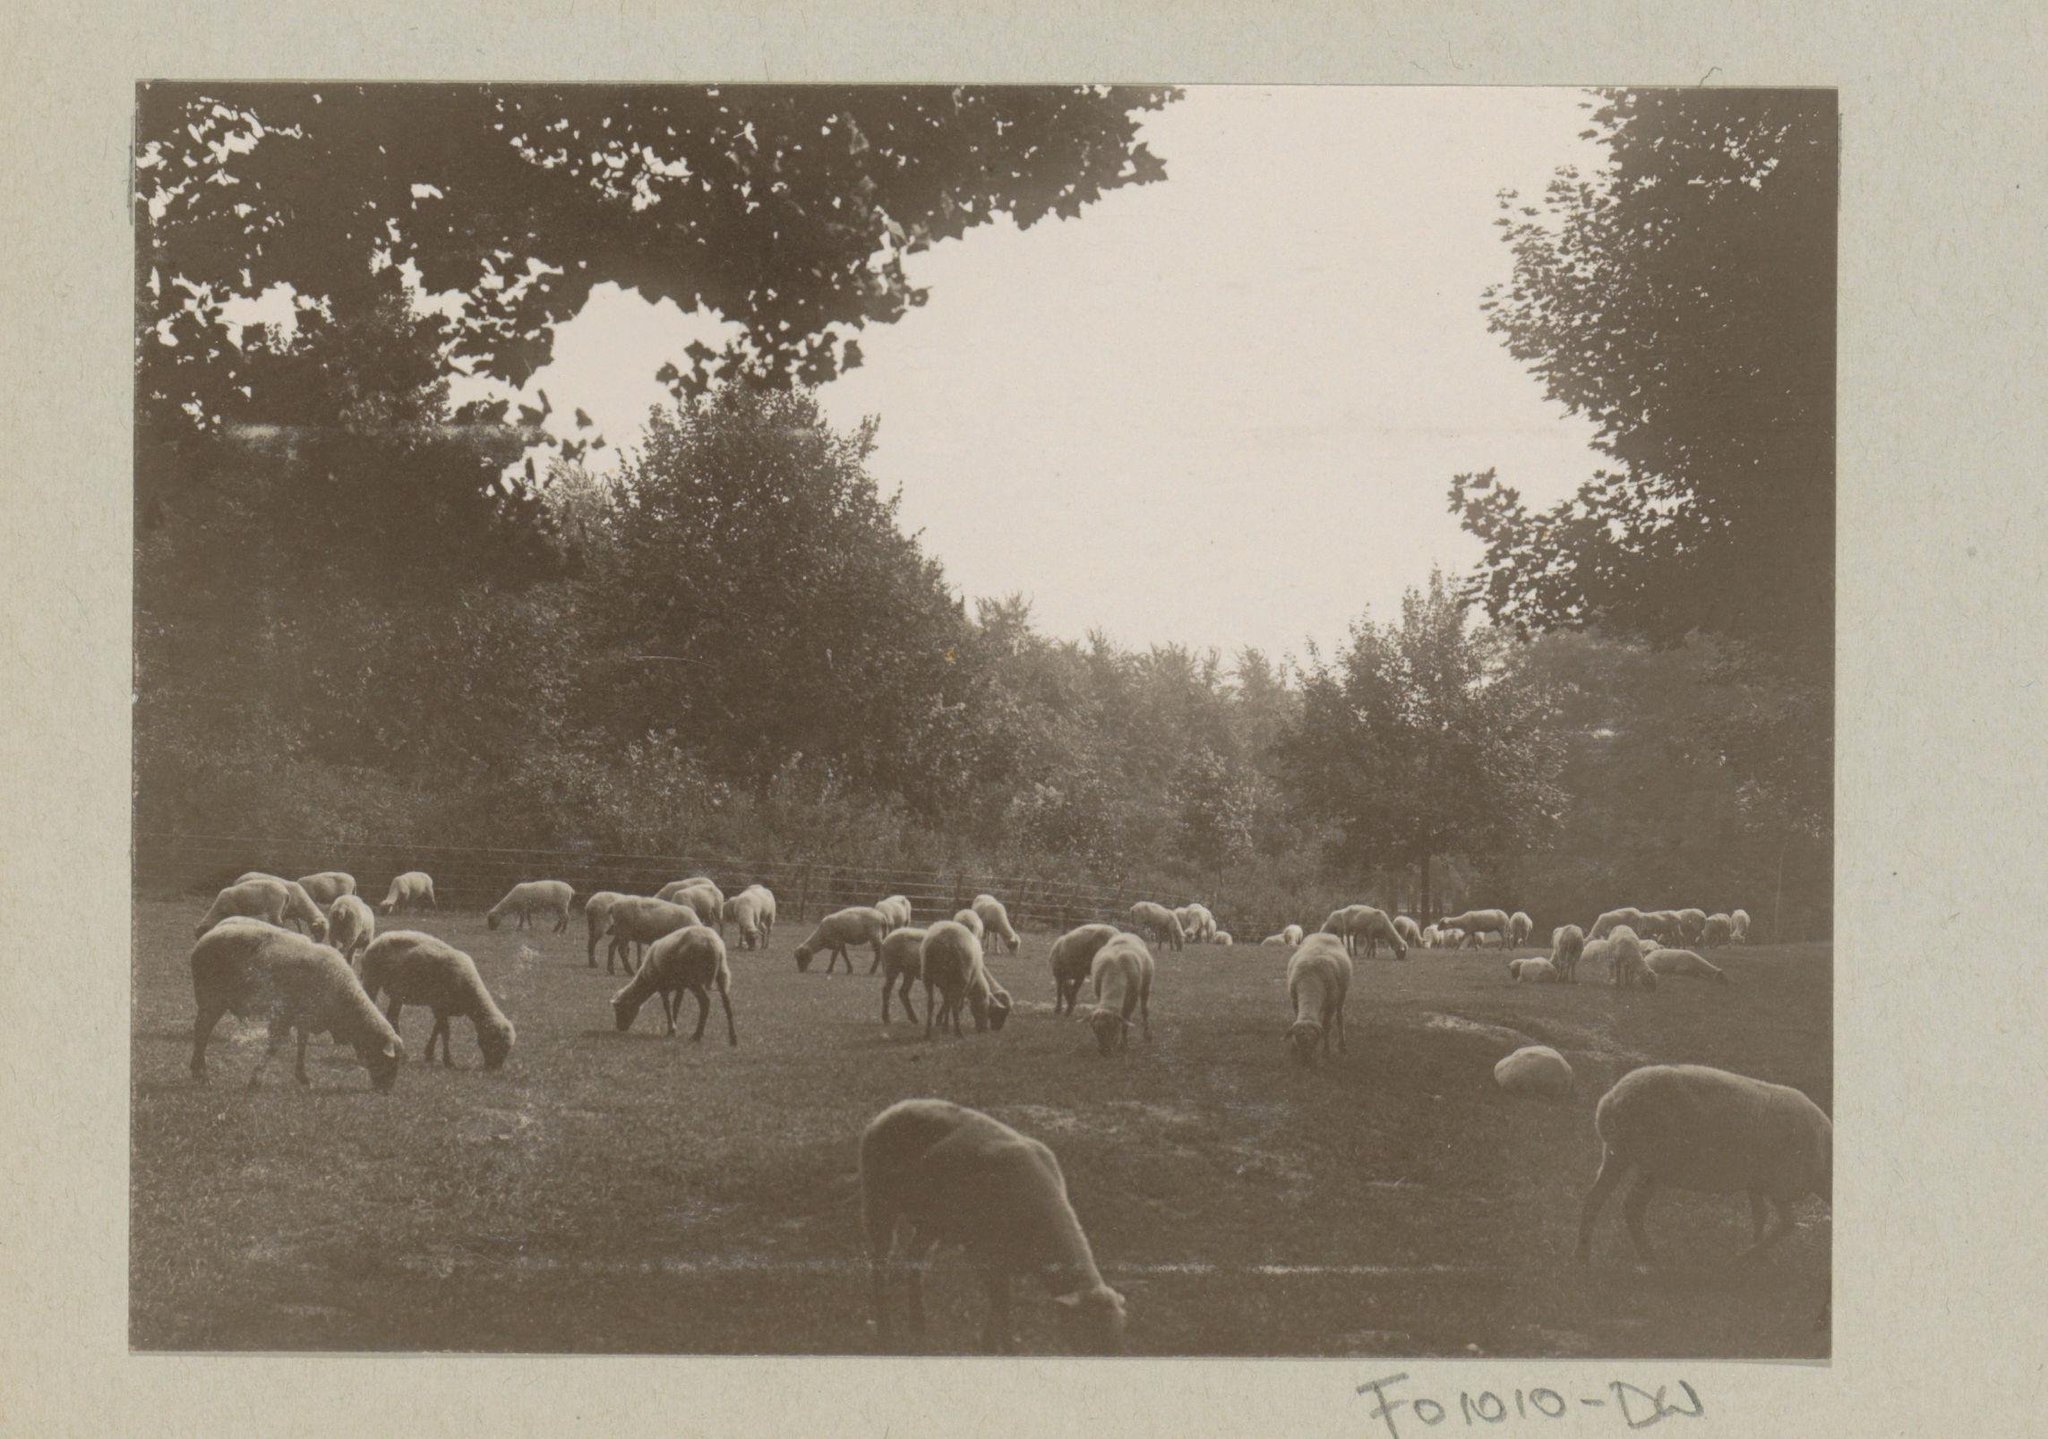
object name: photograph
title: Kudde schapen in een weide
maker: Anonymous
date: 1900-1910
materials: photographic support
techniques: matte daylight collodion silver print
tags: herd, flock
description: Onderdeel van Familiealbum met onder meer foto's van Wijnhandel Kraaij & Co. Bordeaux-Amsterdam.